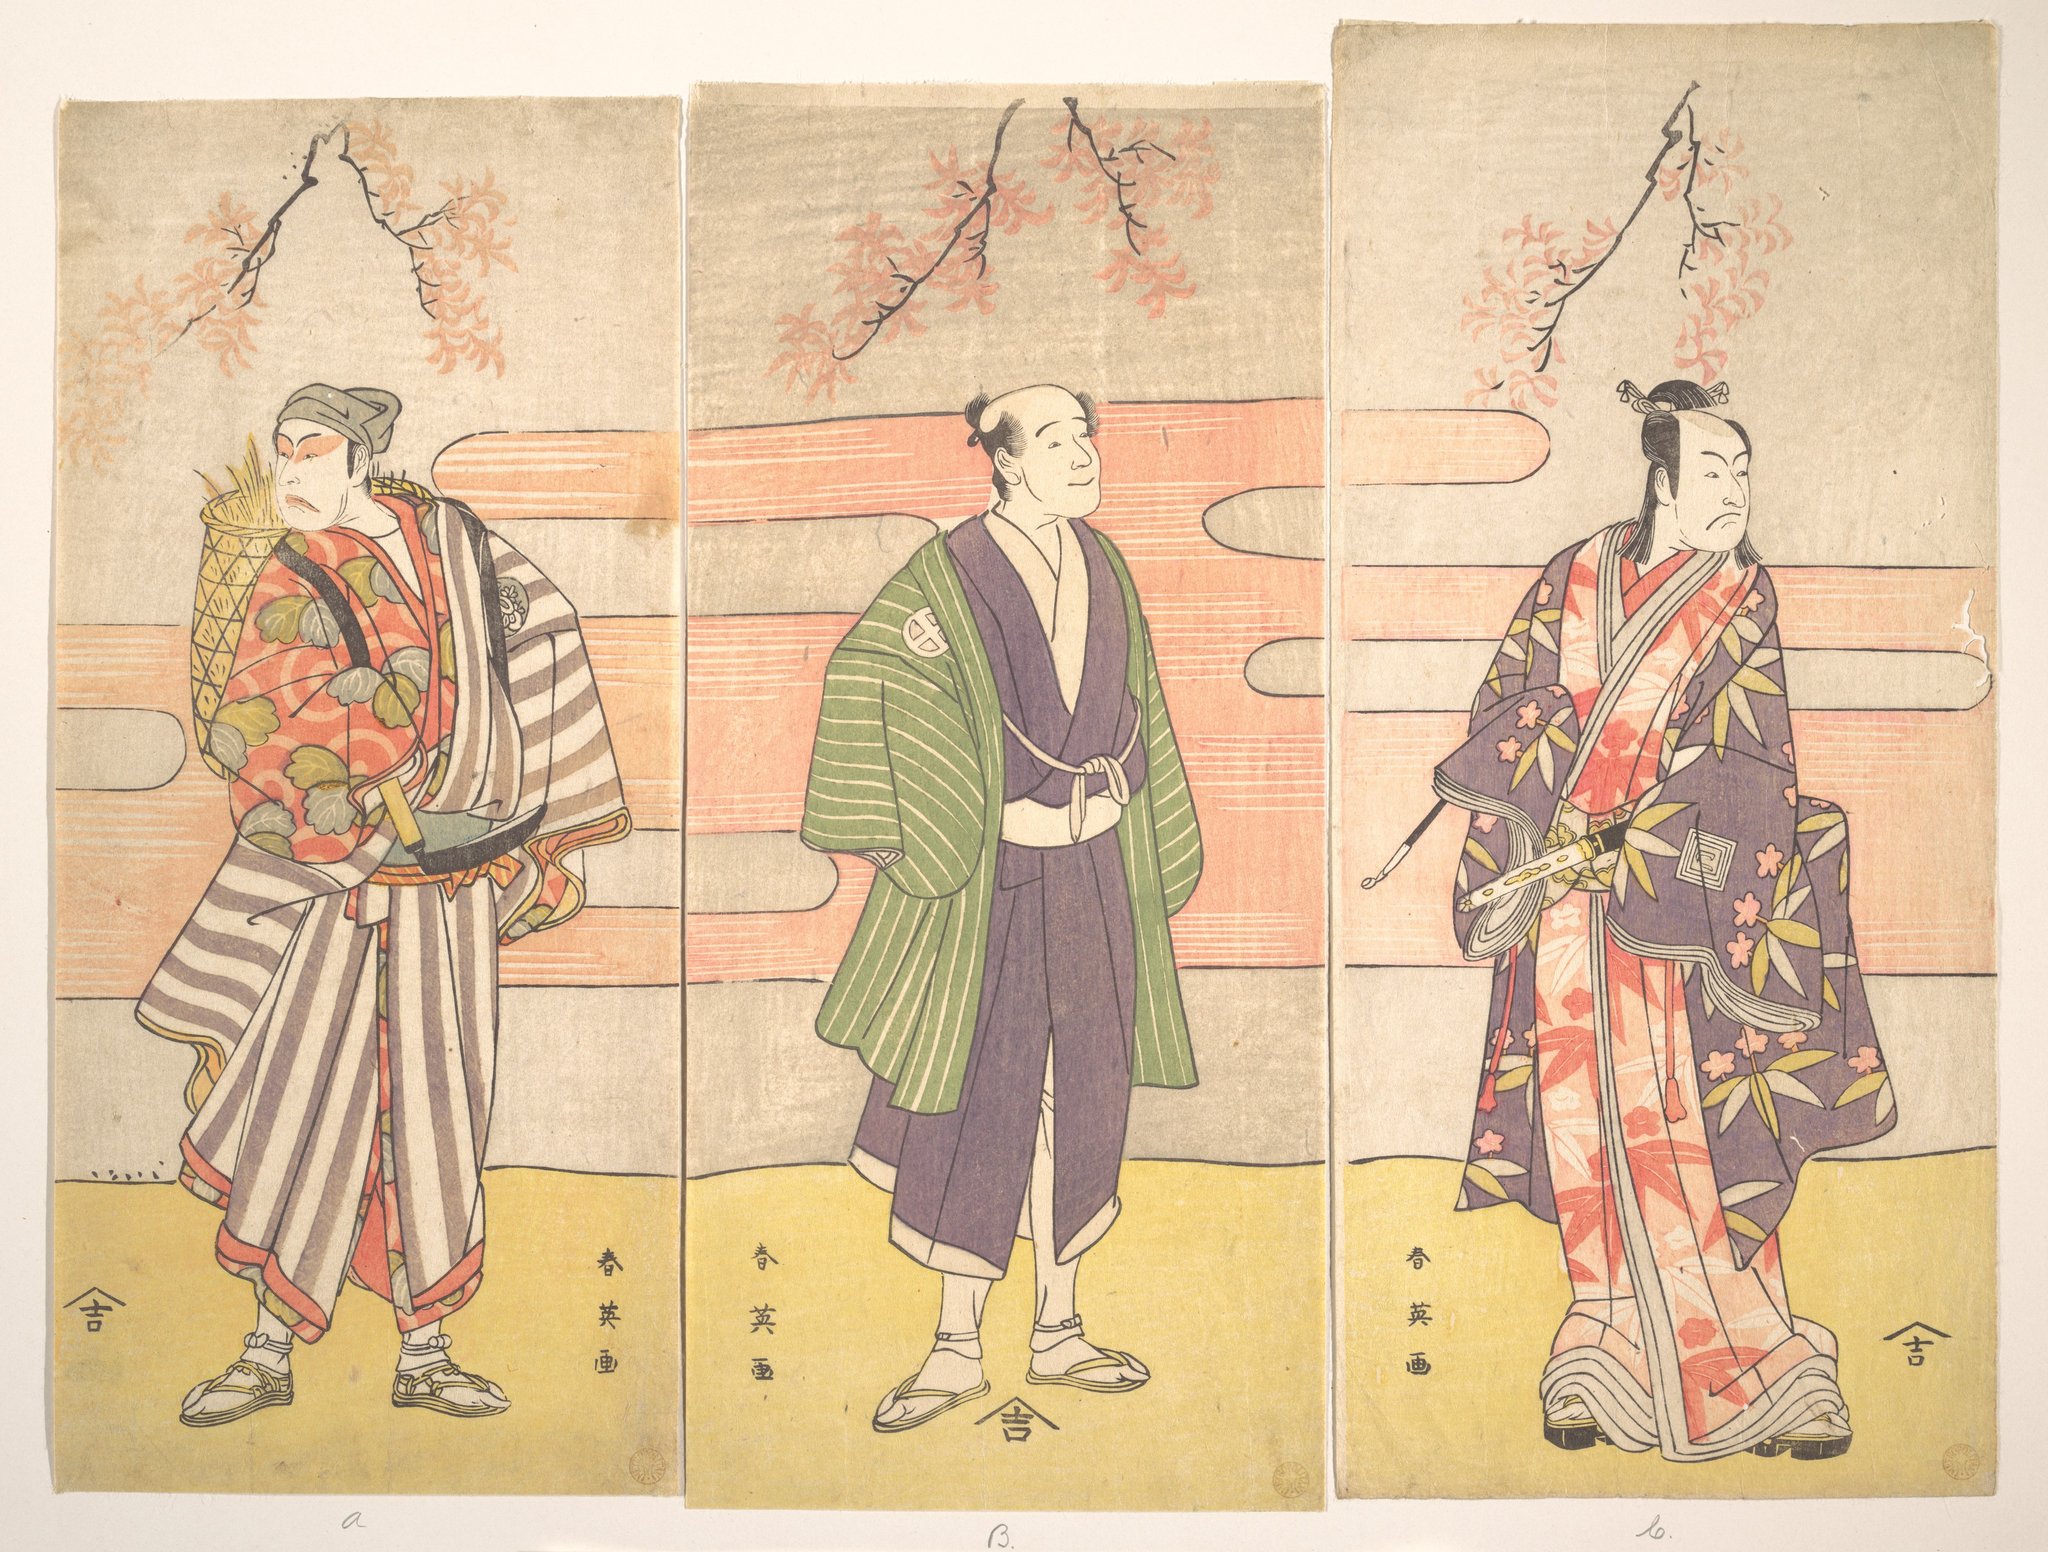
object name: woodblock print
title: An Unidentified Actor as a Farmer with a Basket on His Back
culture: japanese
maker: katsukawa shun'ei 勝川春英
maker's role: artist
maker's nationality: japanese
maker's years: 1762-1819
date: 1793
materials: ink, paper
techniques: woodblock print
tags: men,actors